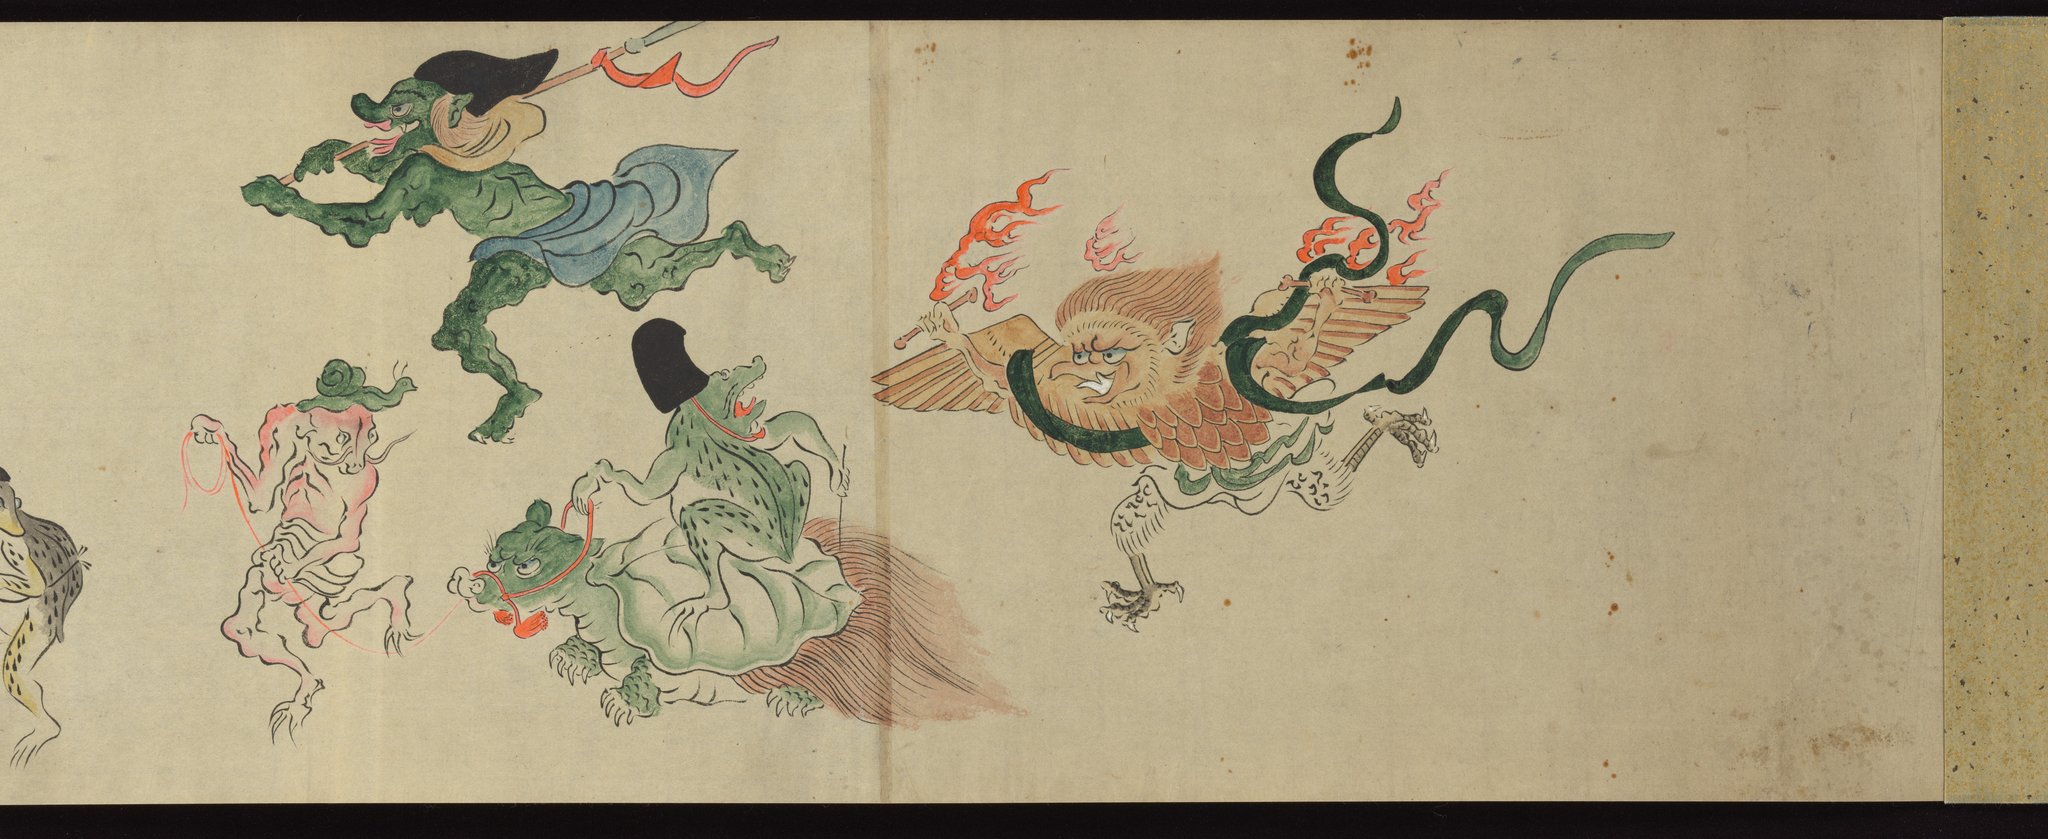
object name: handscroll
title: The Night Parade of One Hundred Demons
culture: japanese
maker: tachibana gadō 橘雅堂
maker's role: artist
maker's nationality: japanese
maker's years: 1868-1899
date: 1892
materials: ink, paper